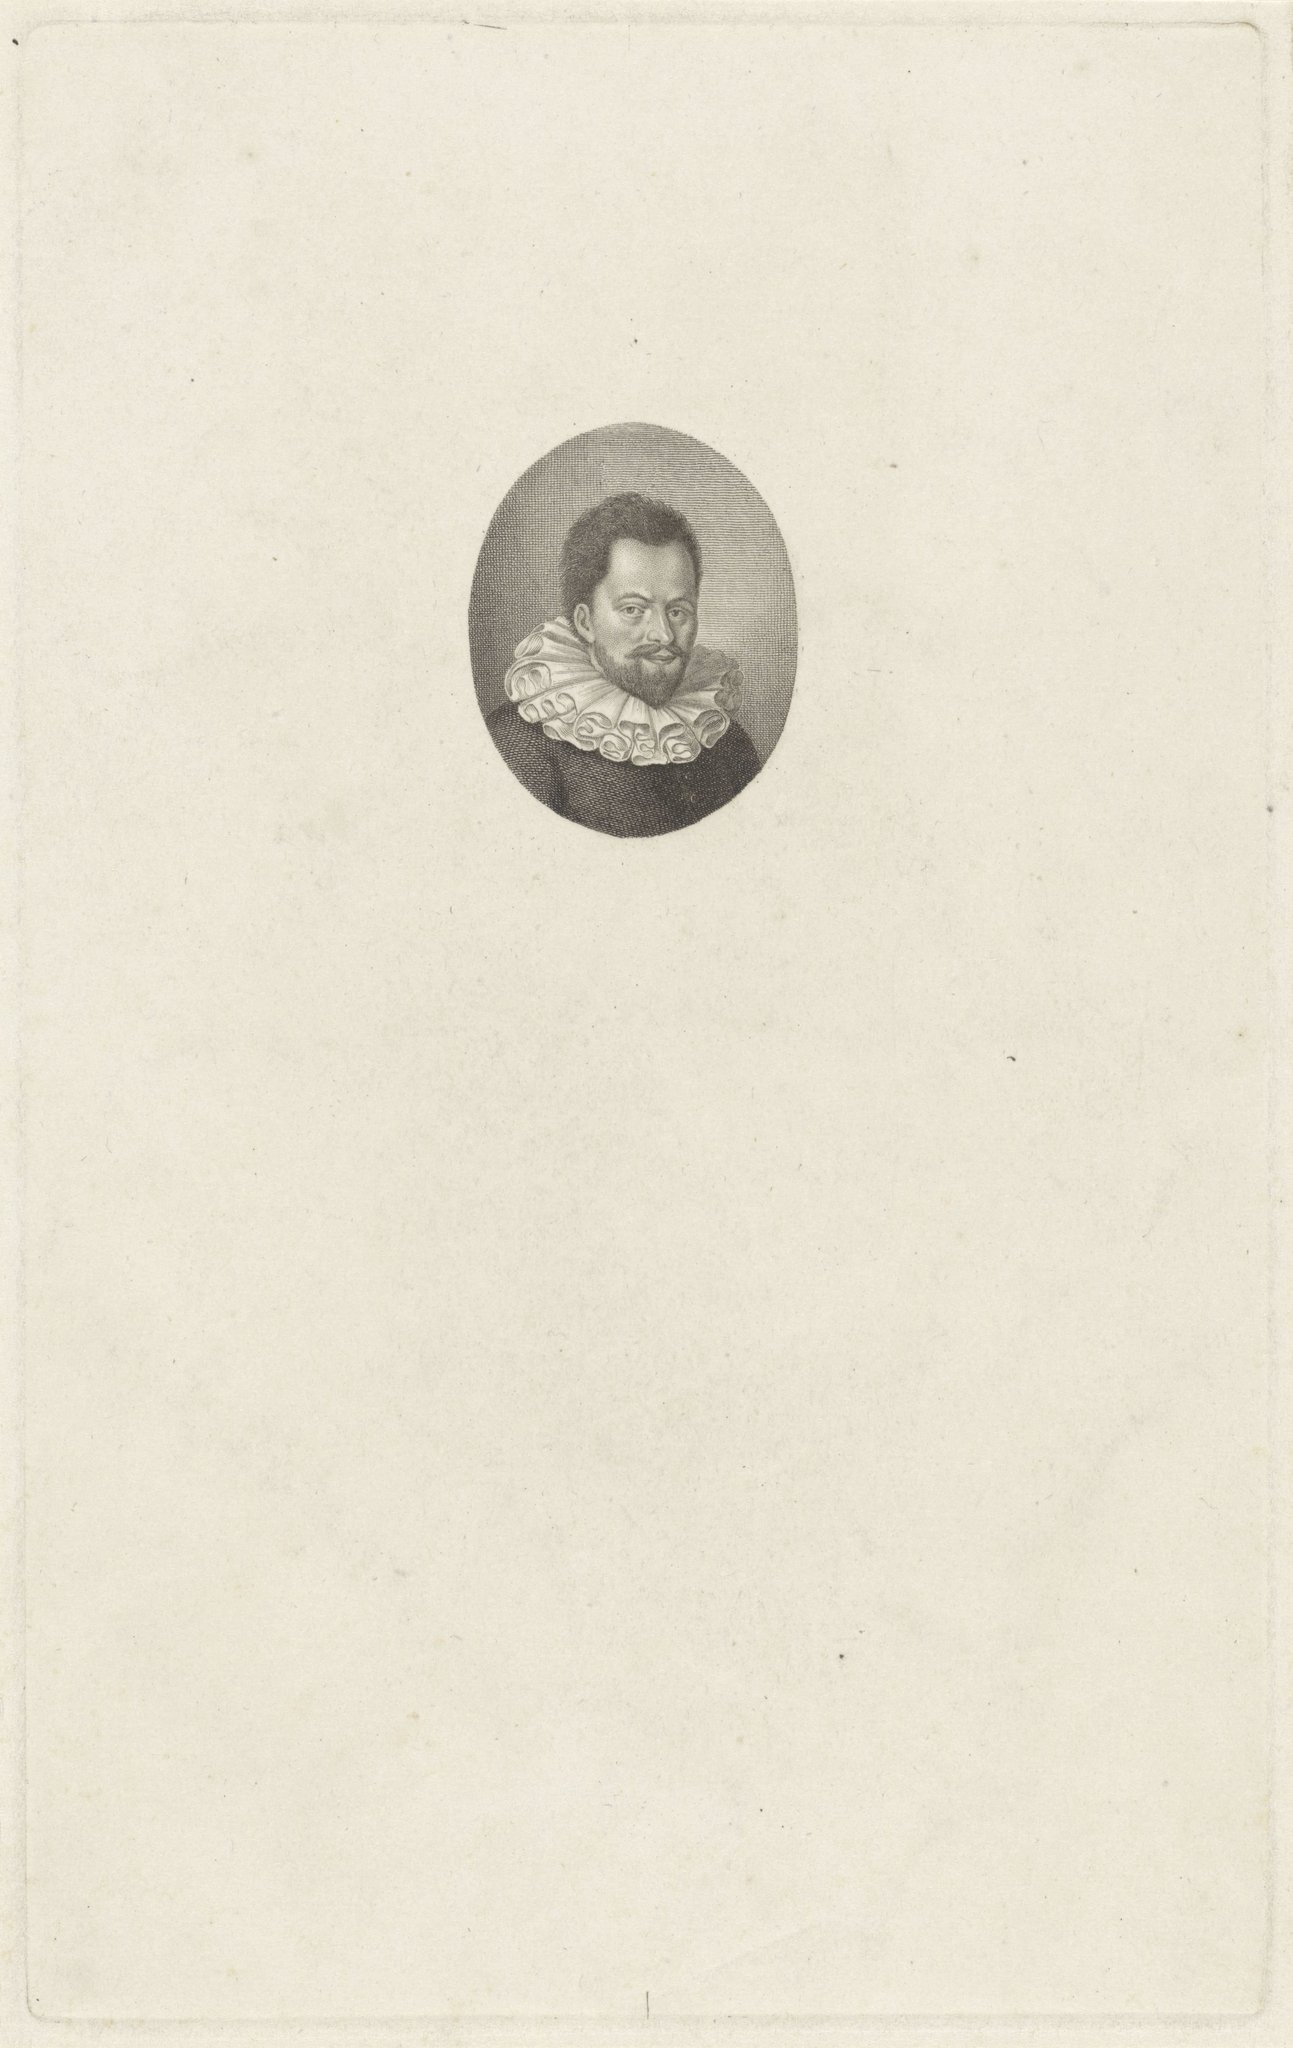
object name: print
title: Portret van Simon Stevin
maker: philippus velijn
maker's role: print maker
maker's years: 1787-1836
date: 1821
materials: paper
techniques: etching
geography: netherlands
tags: simon stevin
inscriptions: collector's mark: Lugt 2228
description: Prent volgens Van Someren ook gebruikt als boekillustratie in: Capelle J.P. van. Bijdragen tot de geschiedenis der wetenschappen en letteren in Nederland. Amsterdam, 1821.